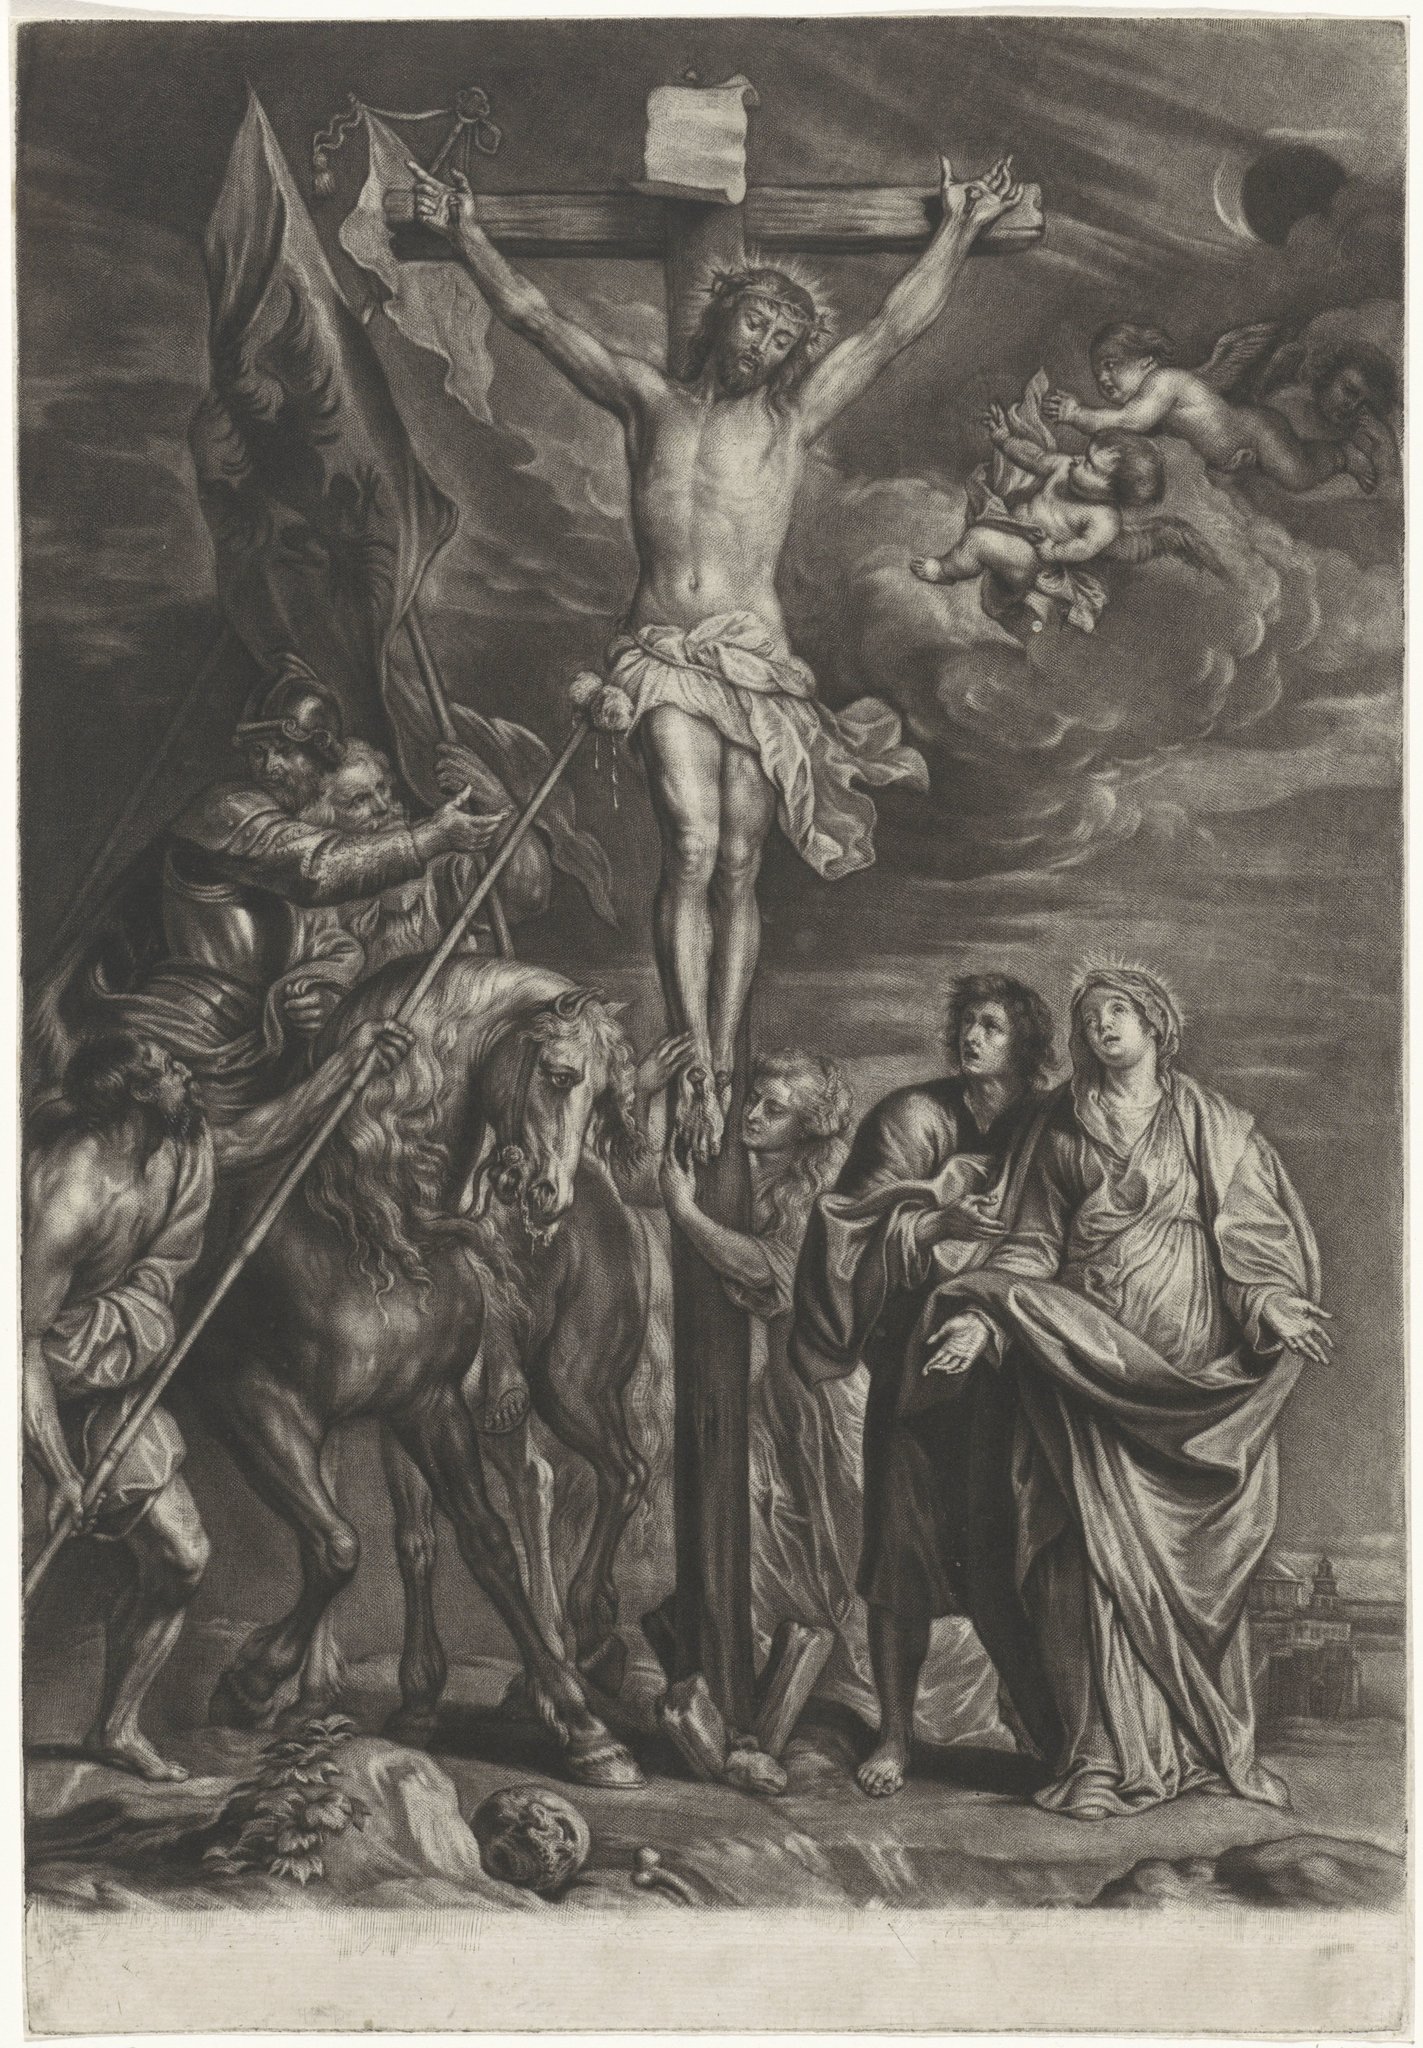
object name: print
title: Christus aan het kruis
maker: jacob gole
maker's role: print maker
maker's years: 1660-1724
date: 1670-1724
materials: paper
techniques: mezzotint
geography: amsterdam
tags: comprehensive representations of the events on golgotha during christ's hanging on the cross, no particular event emphasized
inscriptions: collector's mark: Lugt 2228